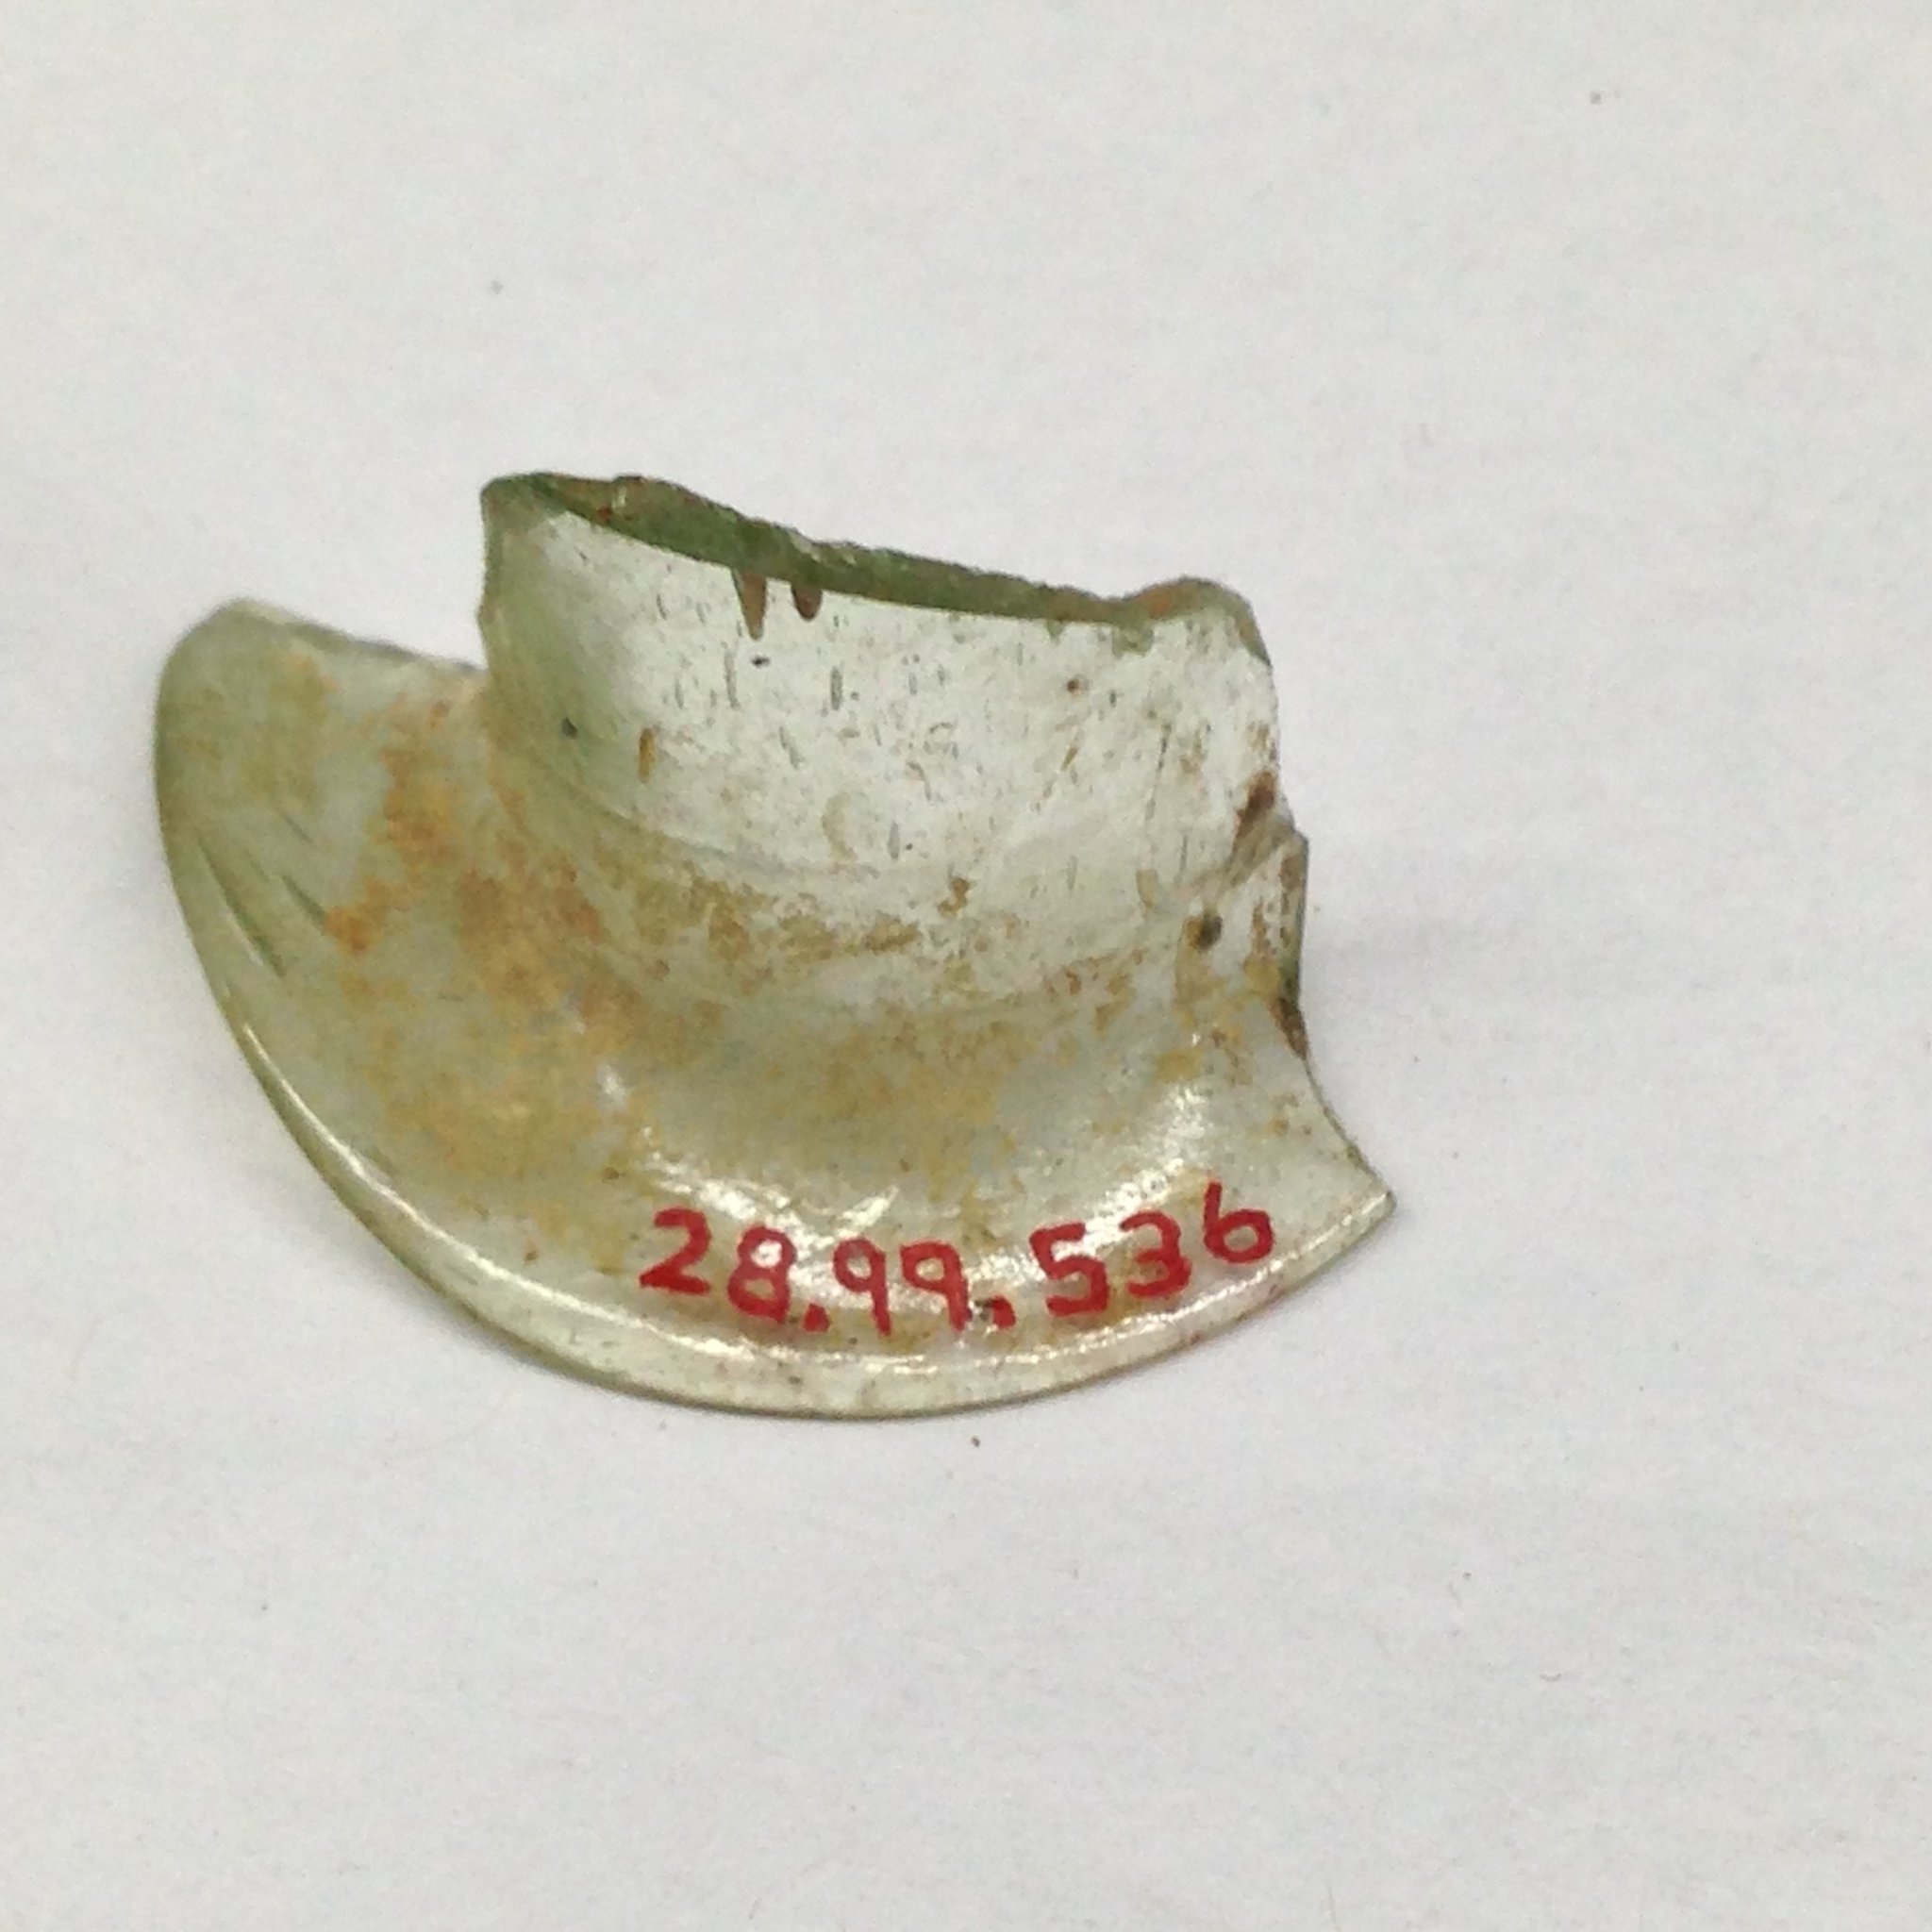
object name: fragment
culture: european or middle eastern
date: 1150-1250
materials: ceramic, glass